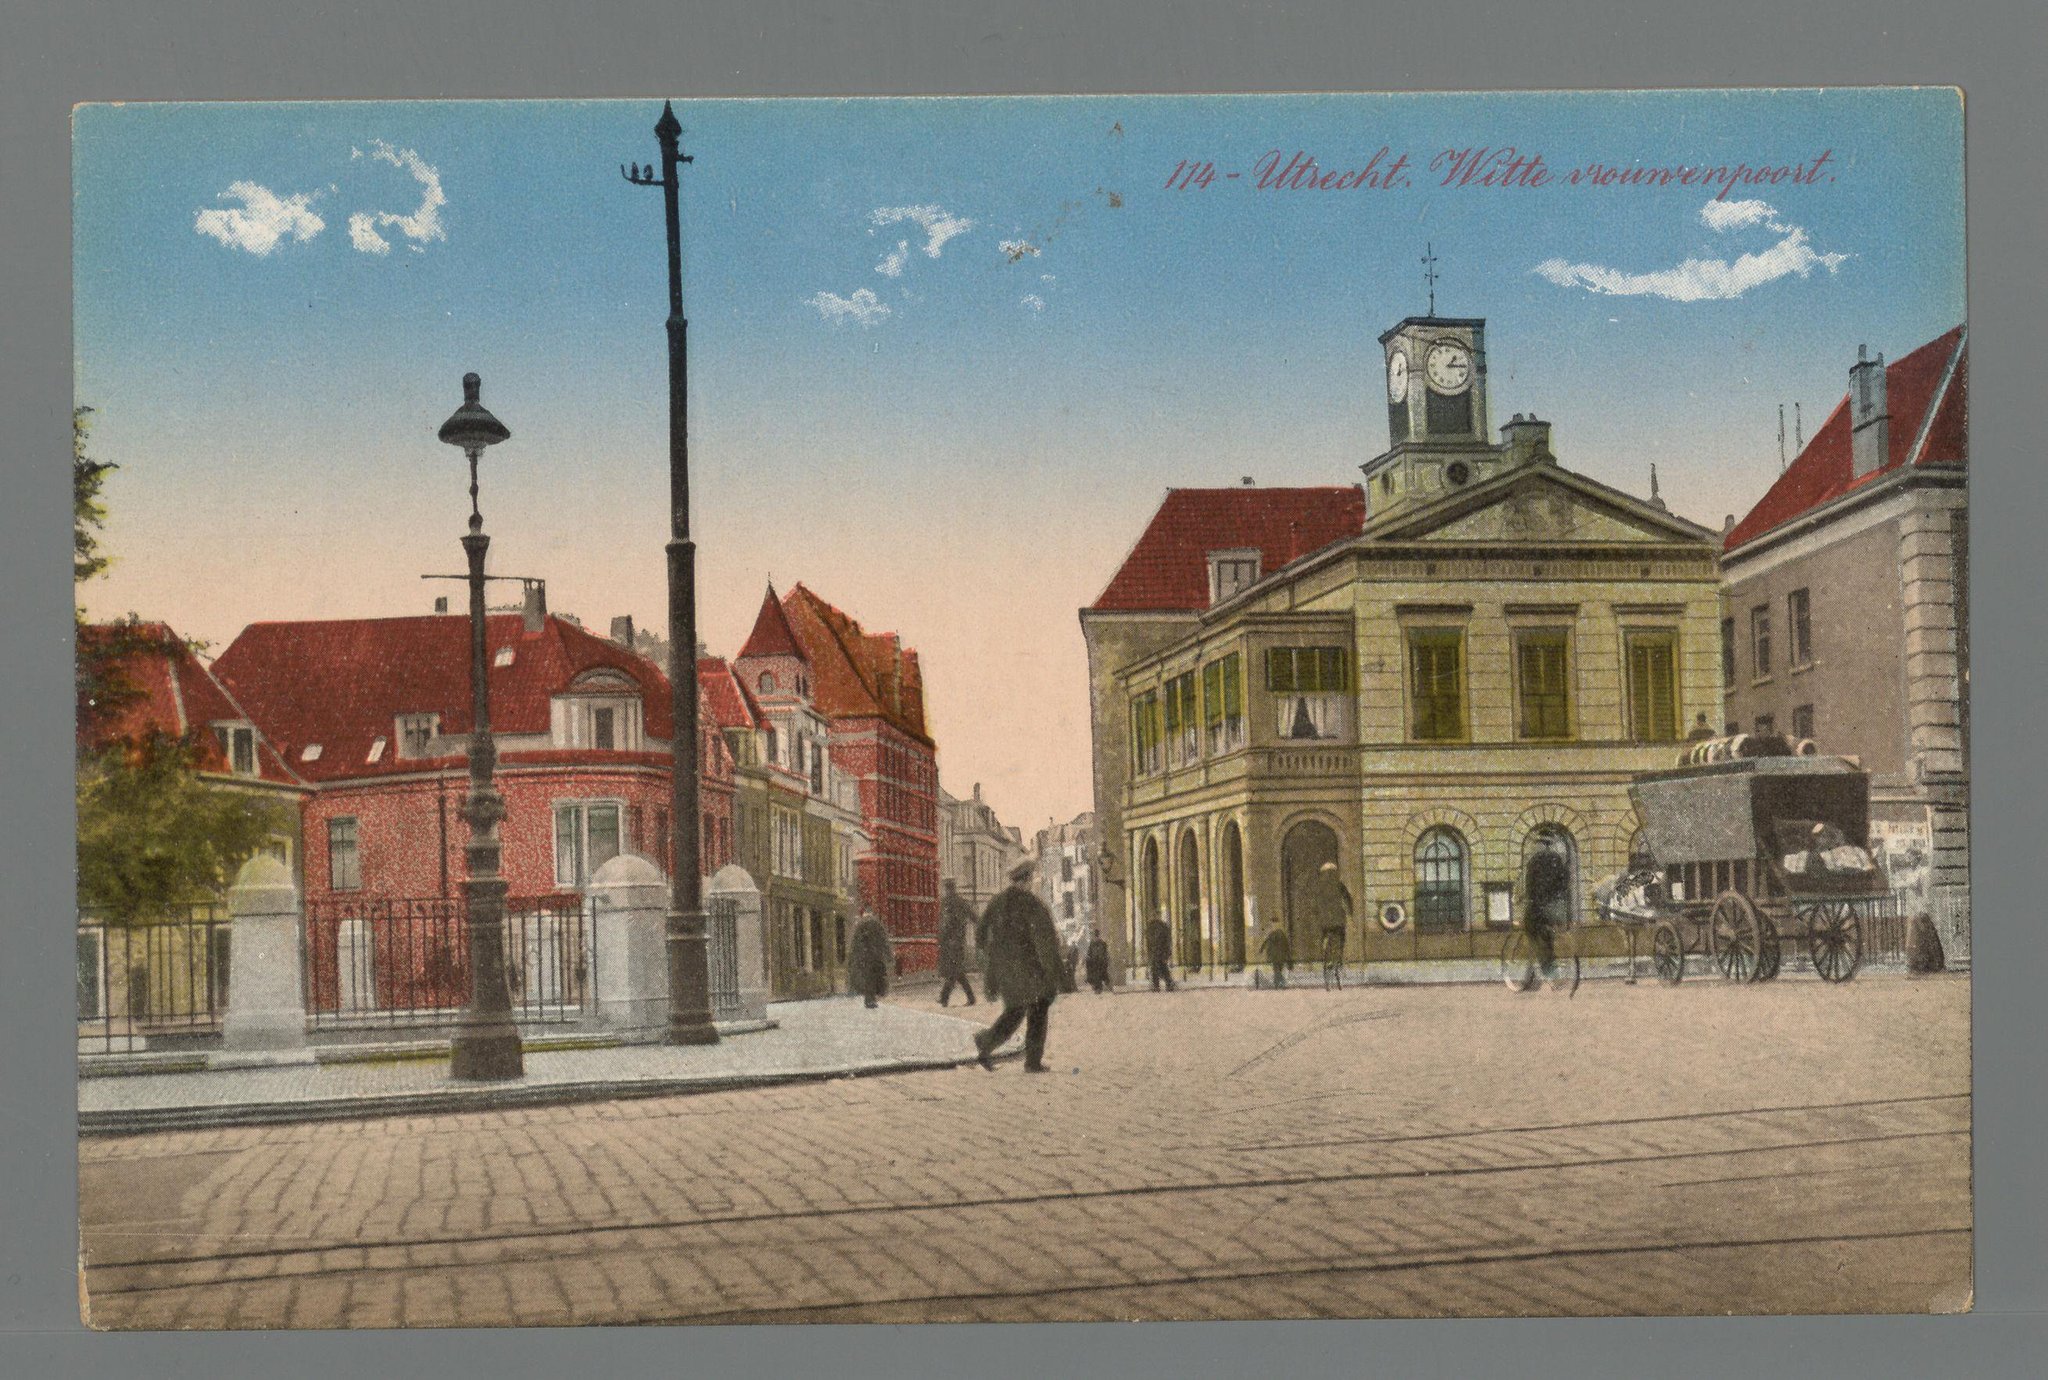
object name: photomechanical print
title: Utrecht. Witte vrouwenpoort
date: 1905-1930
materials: cardboard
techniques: lithograph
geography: utrecht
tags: street, city-gate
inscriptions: inscription: ‘HTEF’